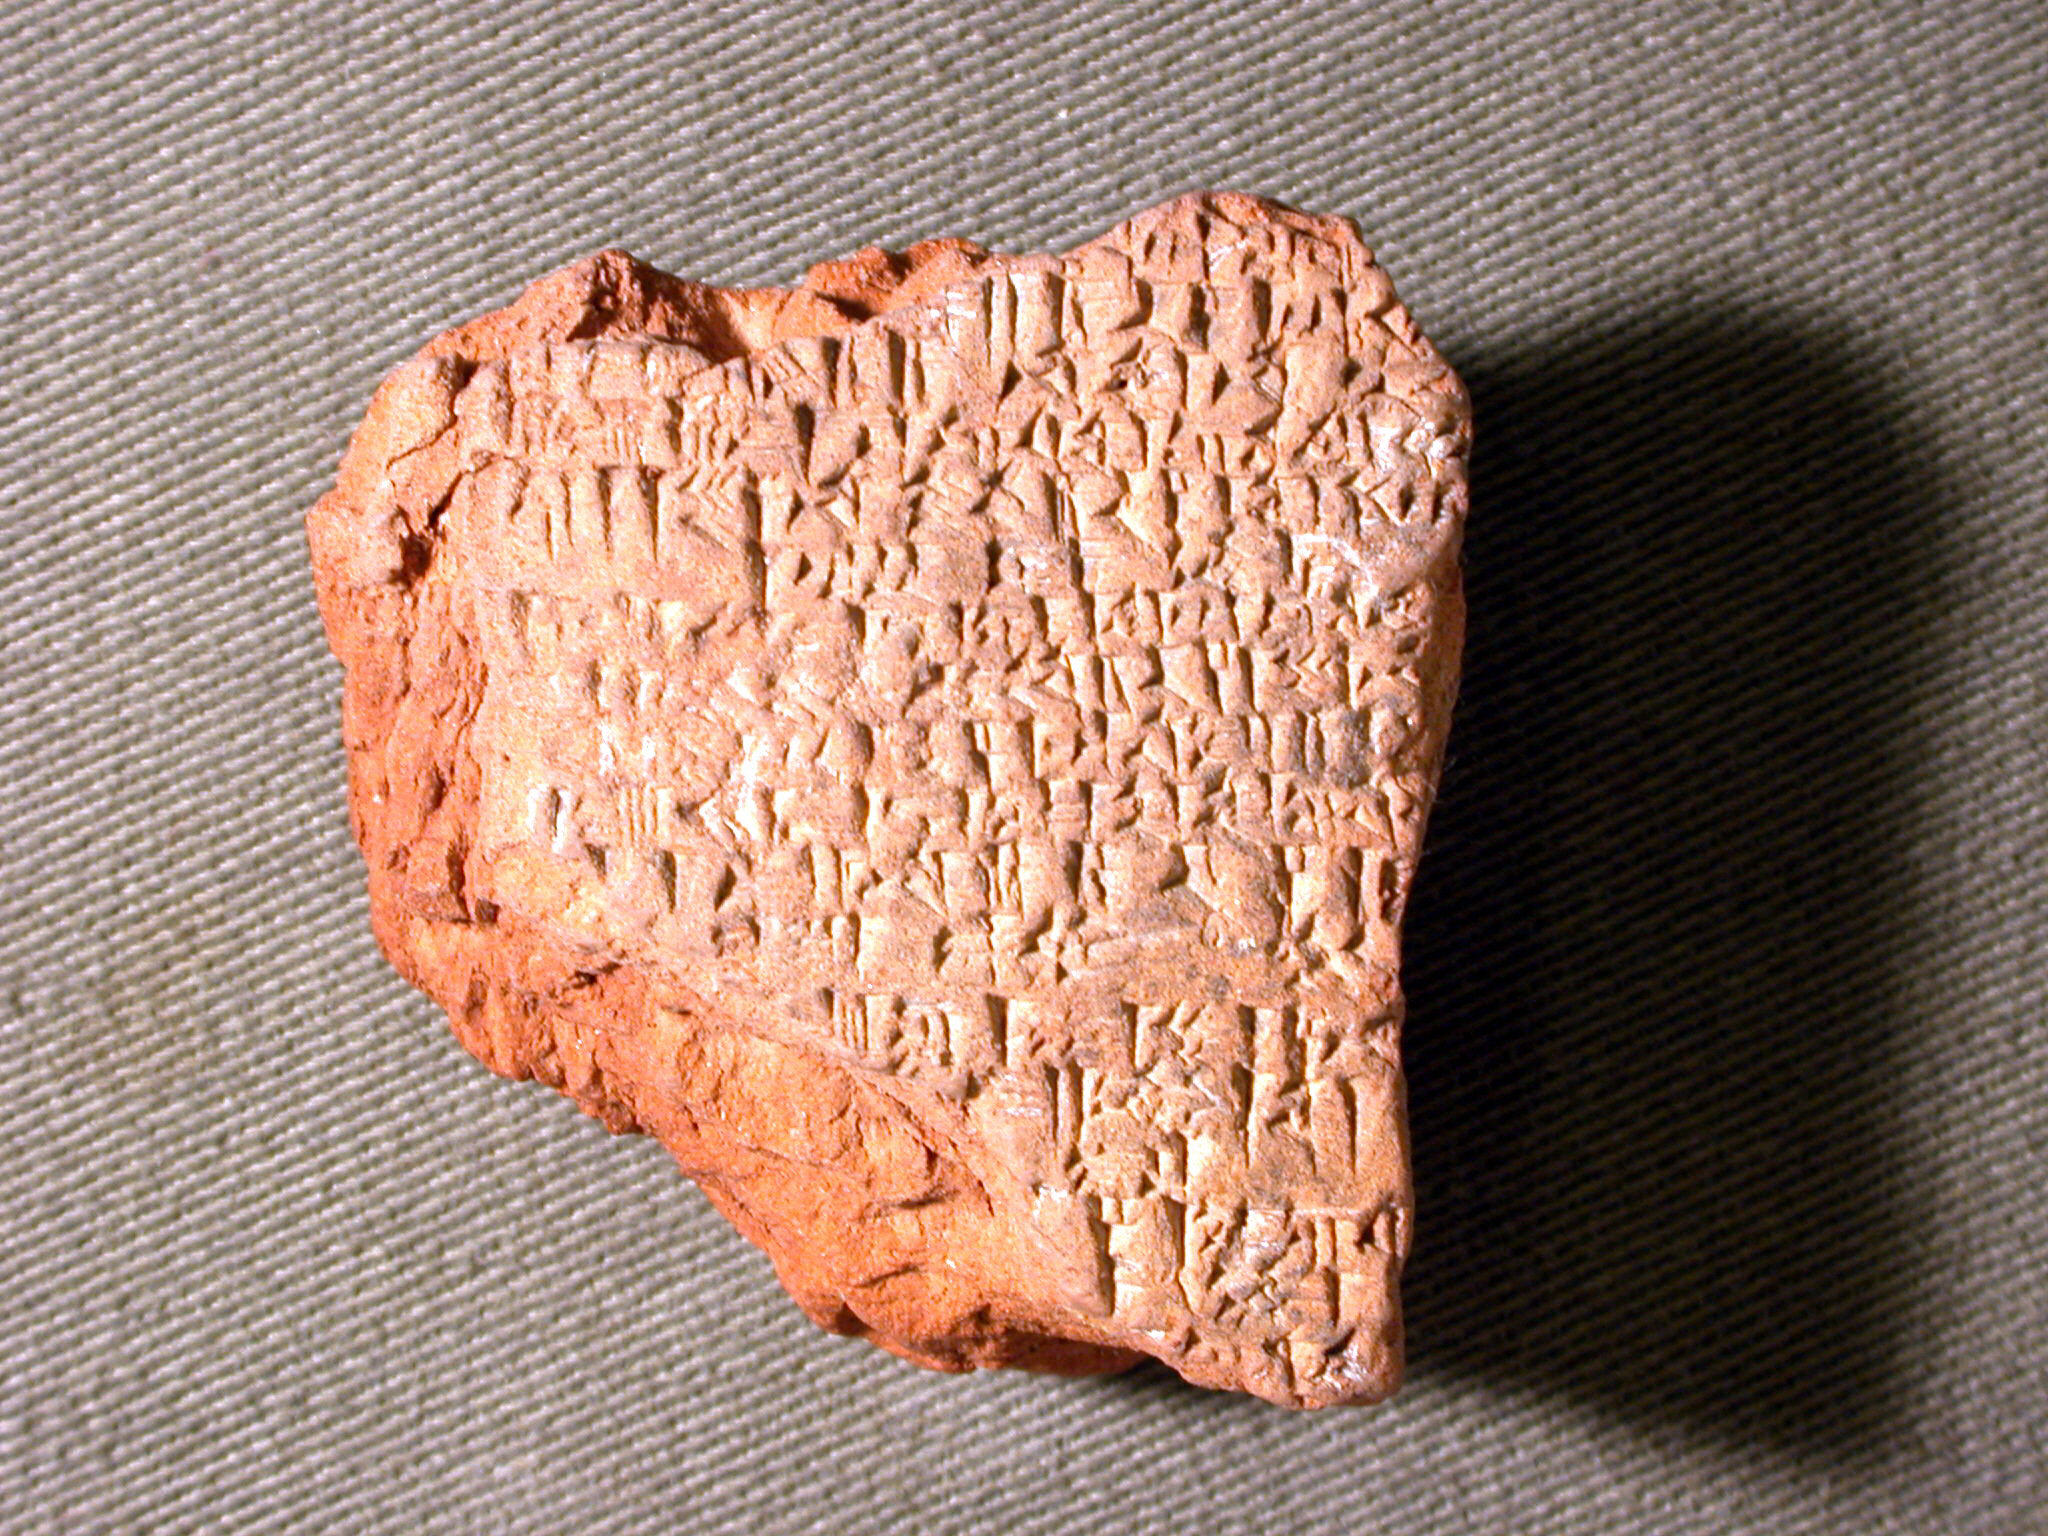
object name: cuneiform tablet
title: Cuneiform tablet: fragment of a contract for the purchase of a house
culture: achaemenid or babylonian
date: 700-301 BCE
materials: clay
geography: mesopotamia